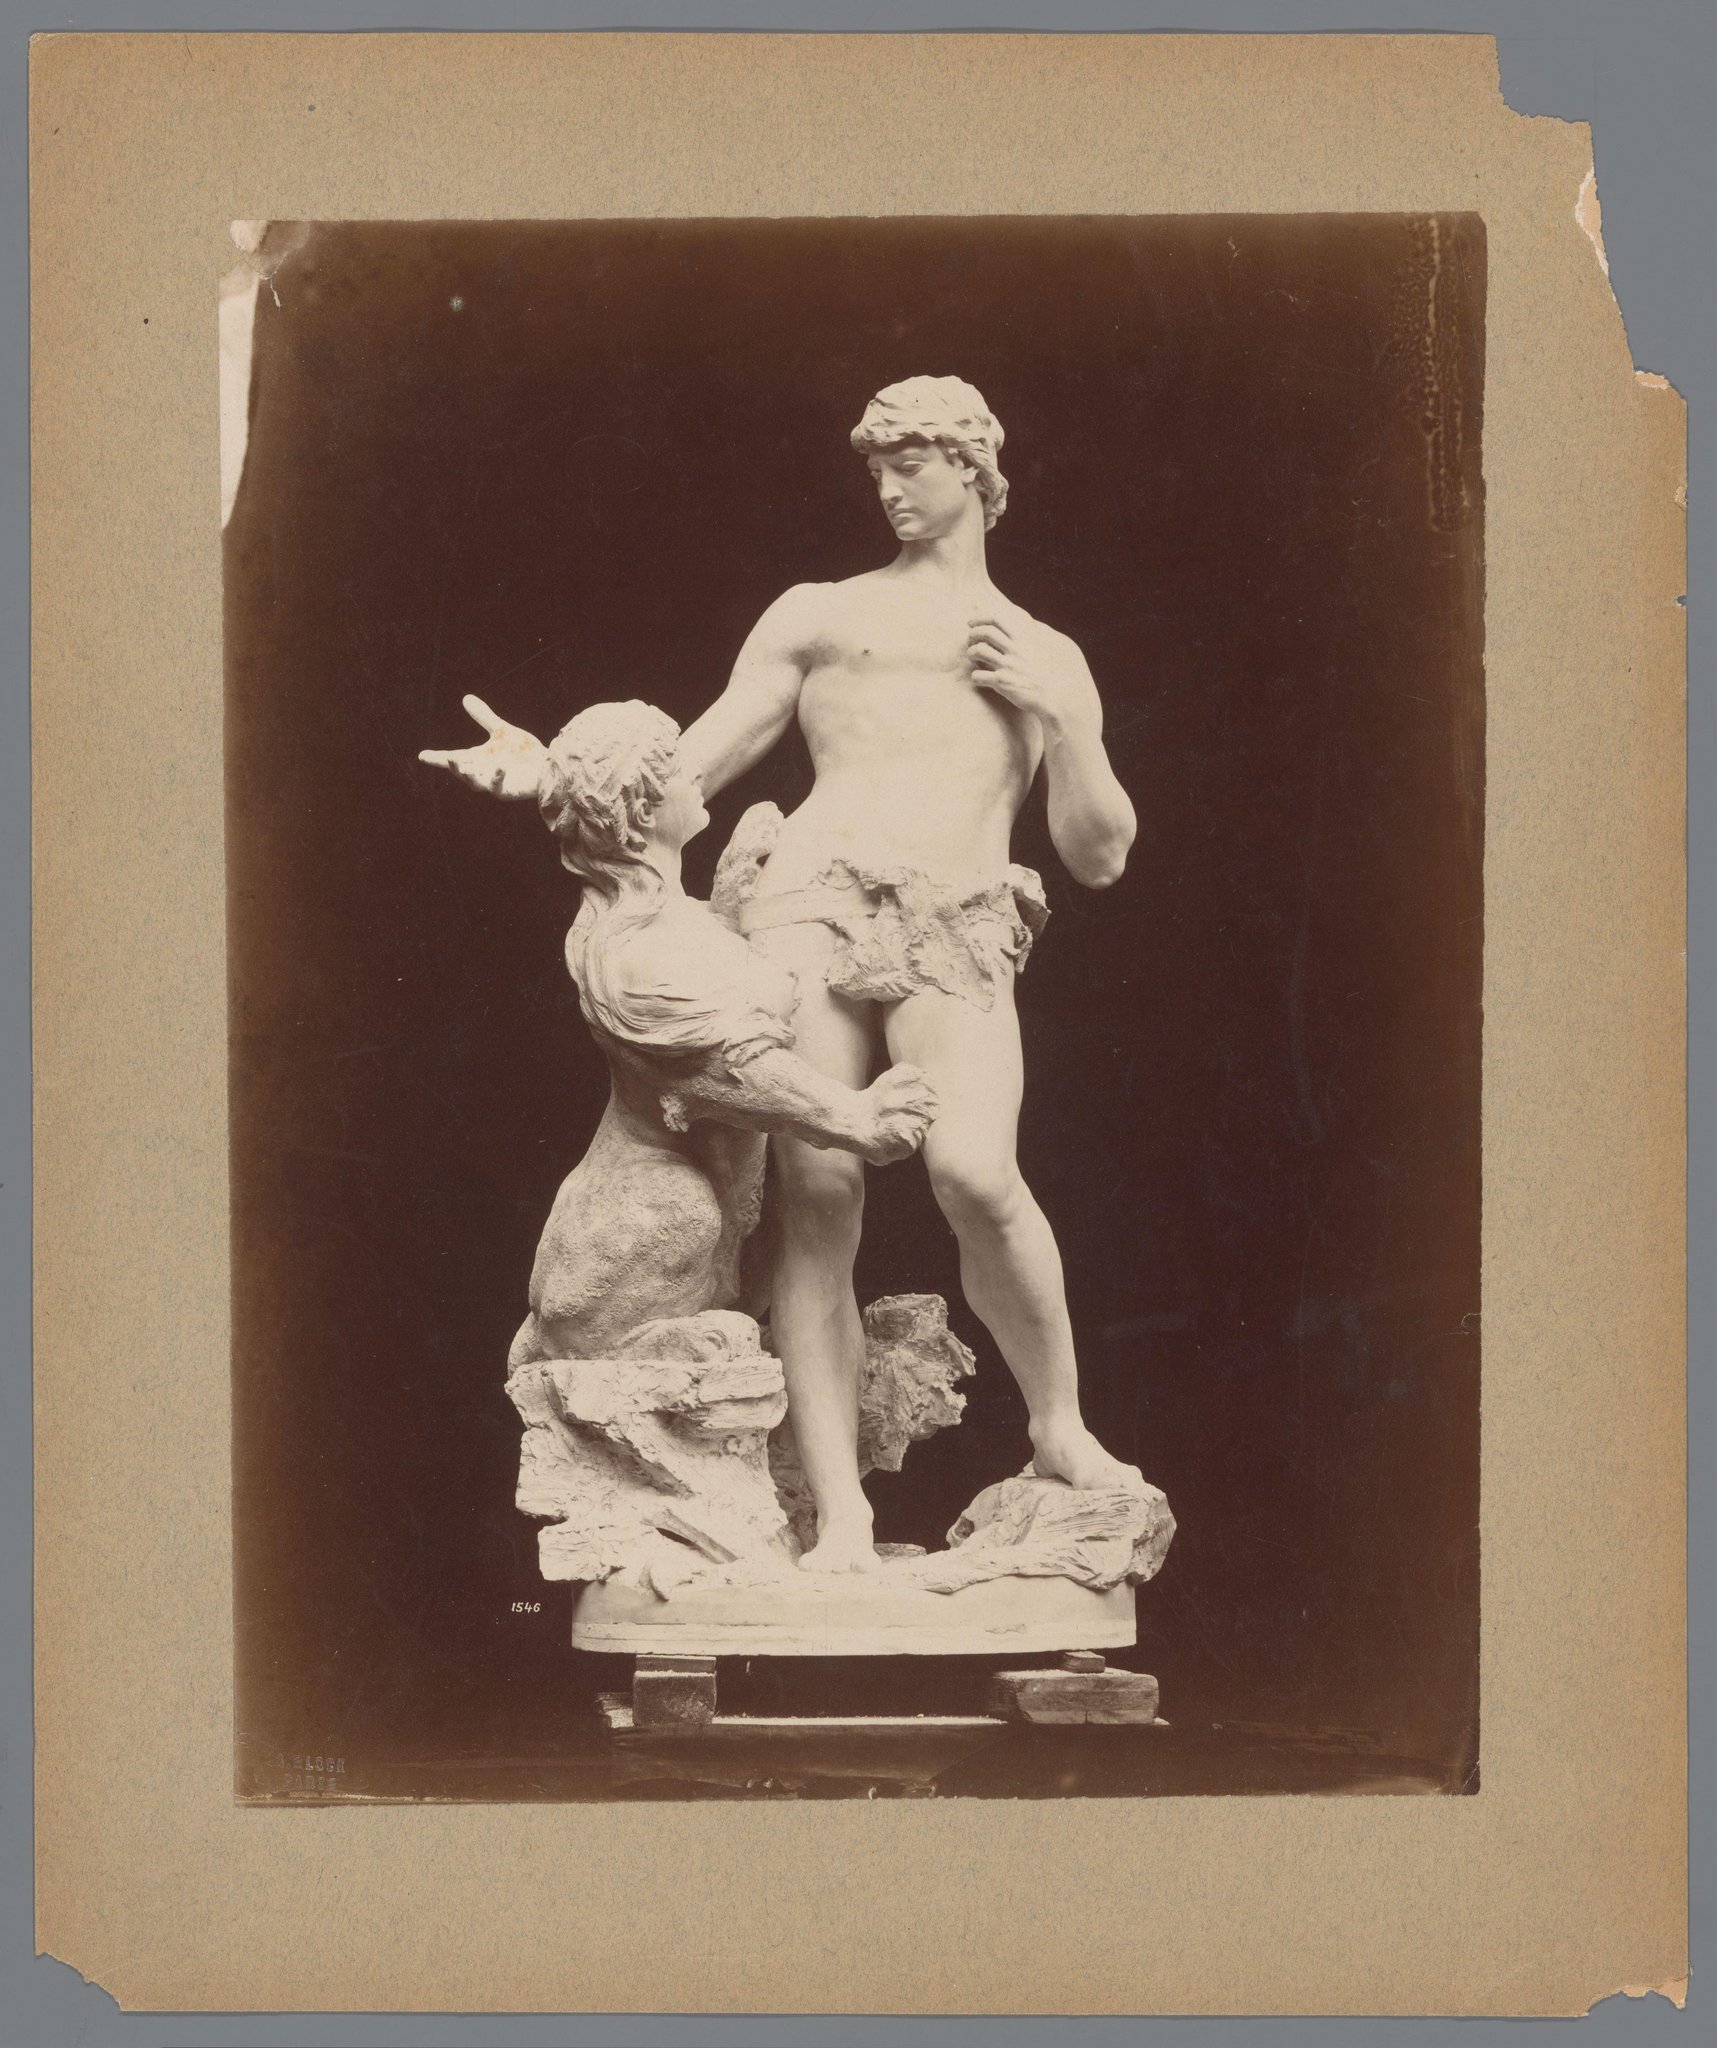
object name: photograph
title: Beeld door A. Lanson, getiteld 'Le Sphinx'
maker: a. block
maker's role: printer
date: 1875-1900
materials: cardboard, photographic support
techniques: albumen print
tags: sphinx (lion/woman); 'sfinge' (ripa), adult man, sculpture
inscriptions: collector's mark: Lugt 3937, inscription: ‘XI pl 9’, name: ‘A. BLOCK PARIS’, number: ‘1546’